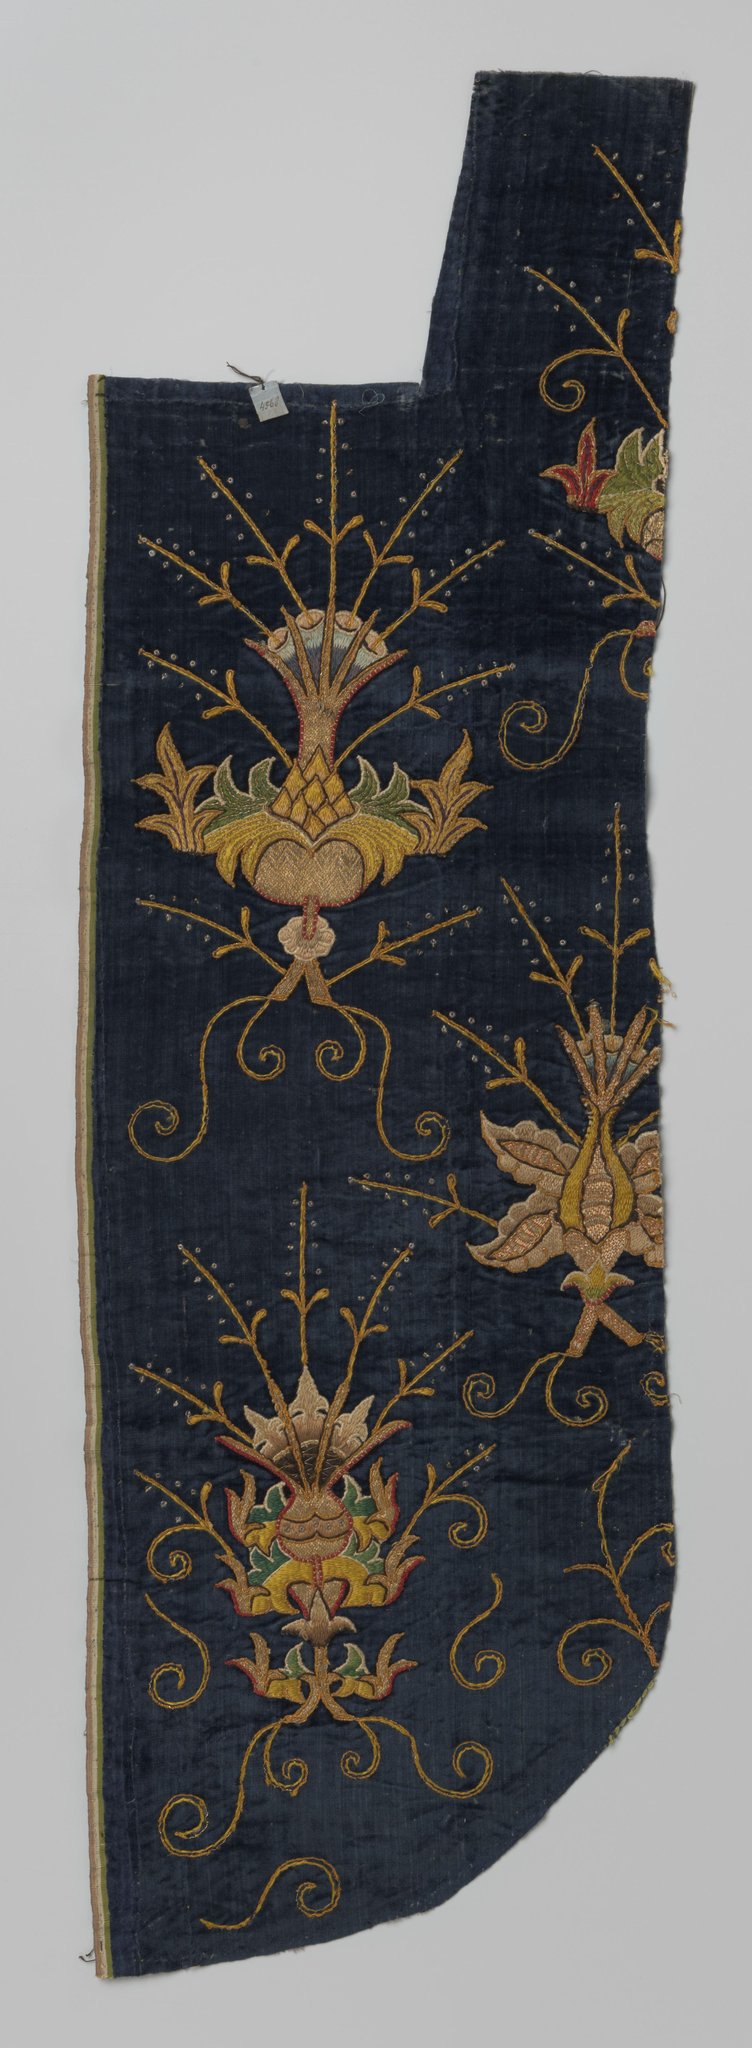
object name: fragment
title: Kazuifel, fragment, met zijde en gouddraad geborduurde bloemen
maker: Anonymous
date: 1500-1525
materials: gold thread, silk, velvet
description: Kazuifel, fragment, met zijde en gouddraad geborduurde bloemen op blauw fluweel